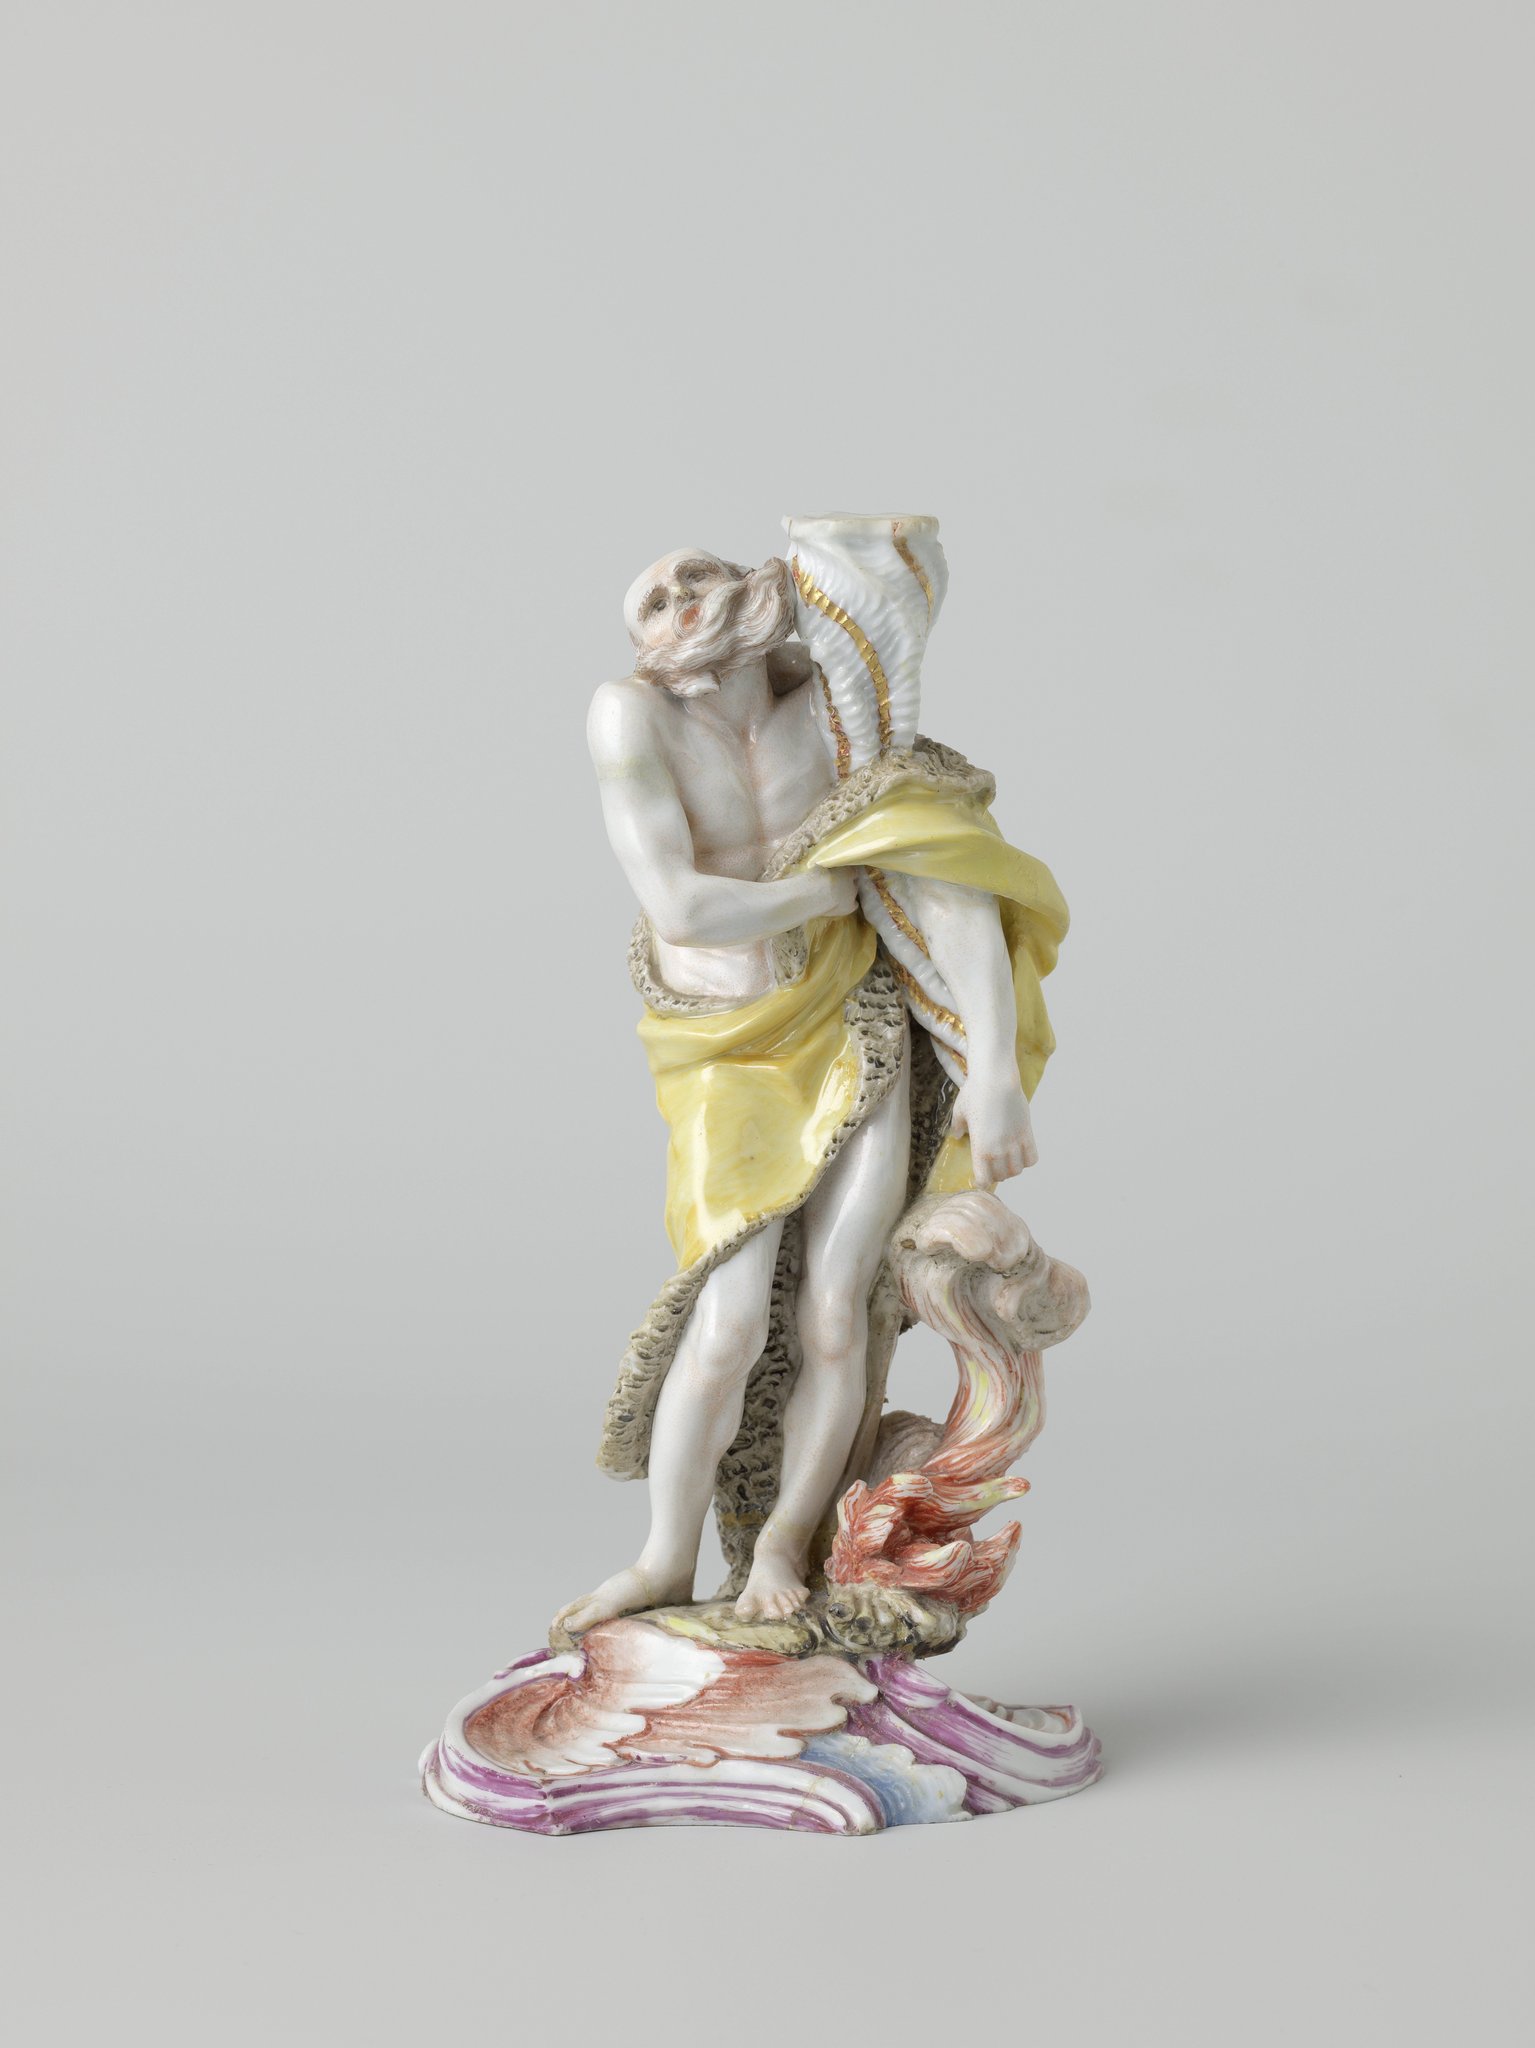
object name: candlestick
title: Figure or candlestick representing Winter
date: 1760-1770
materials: glaze, gold, paint, porcelain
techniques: firing, forming, gilding, vitrification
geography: doccia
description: Autumn and Winter. Porcelain. Doccia (Italy), c. 1760 - 1770, factory of Lorenzo Ginori, models after ivory figures of 1695 by Balthasar Permoser. Given by the Committee for Photographic Sales, 1971.